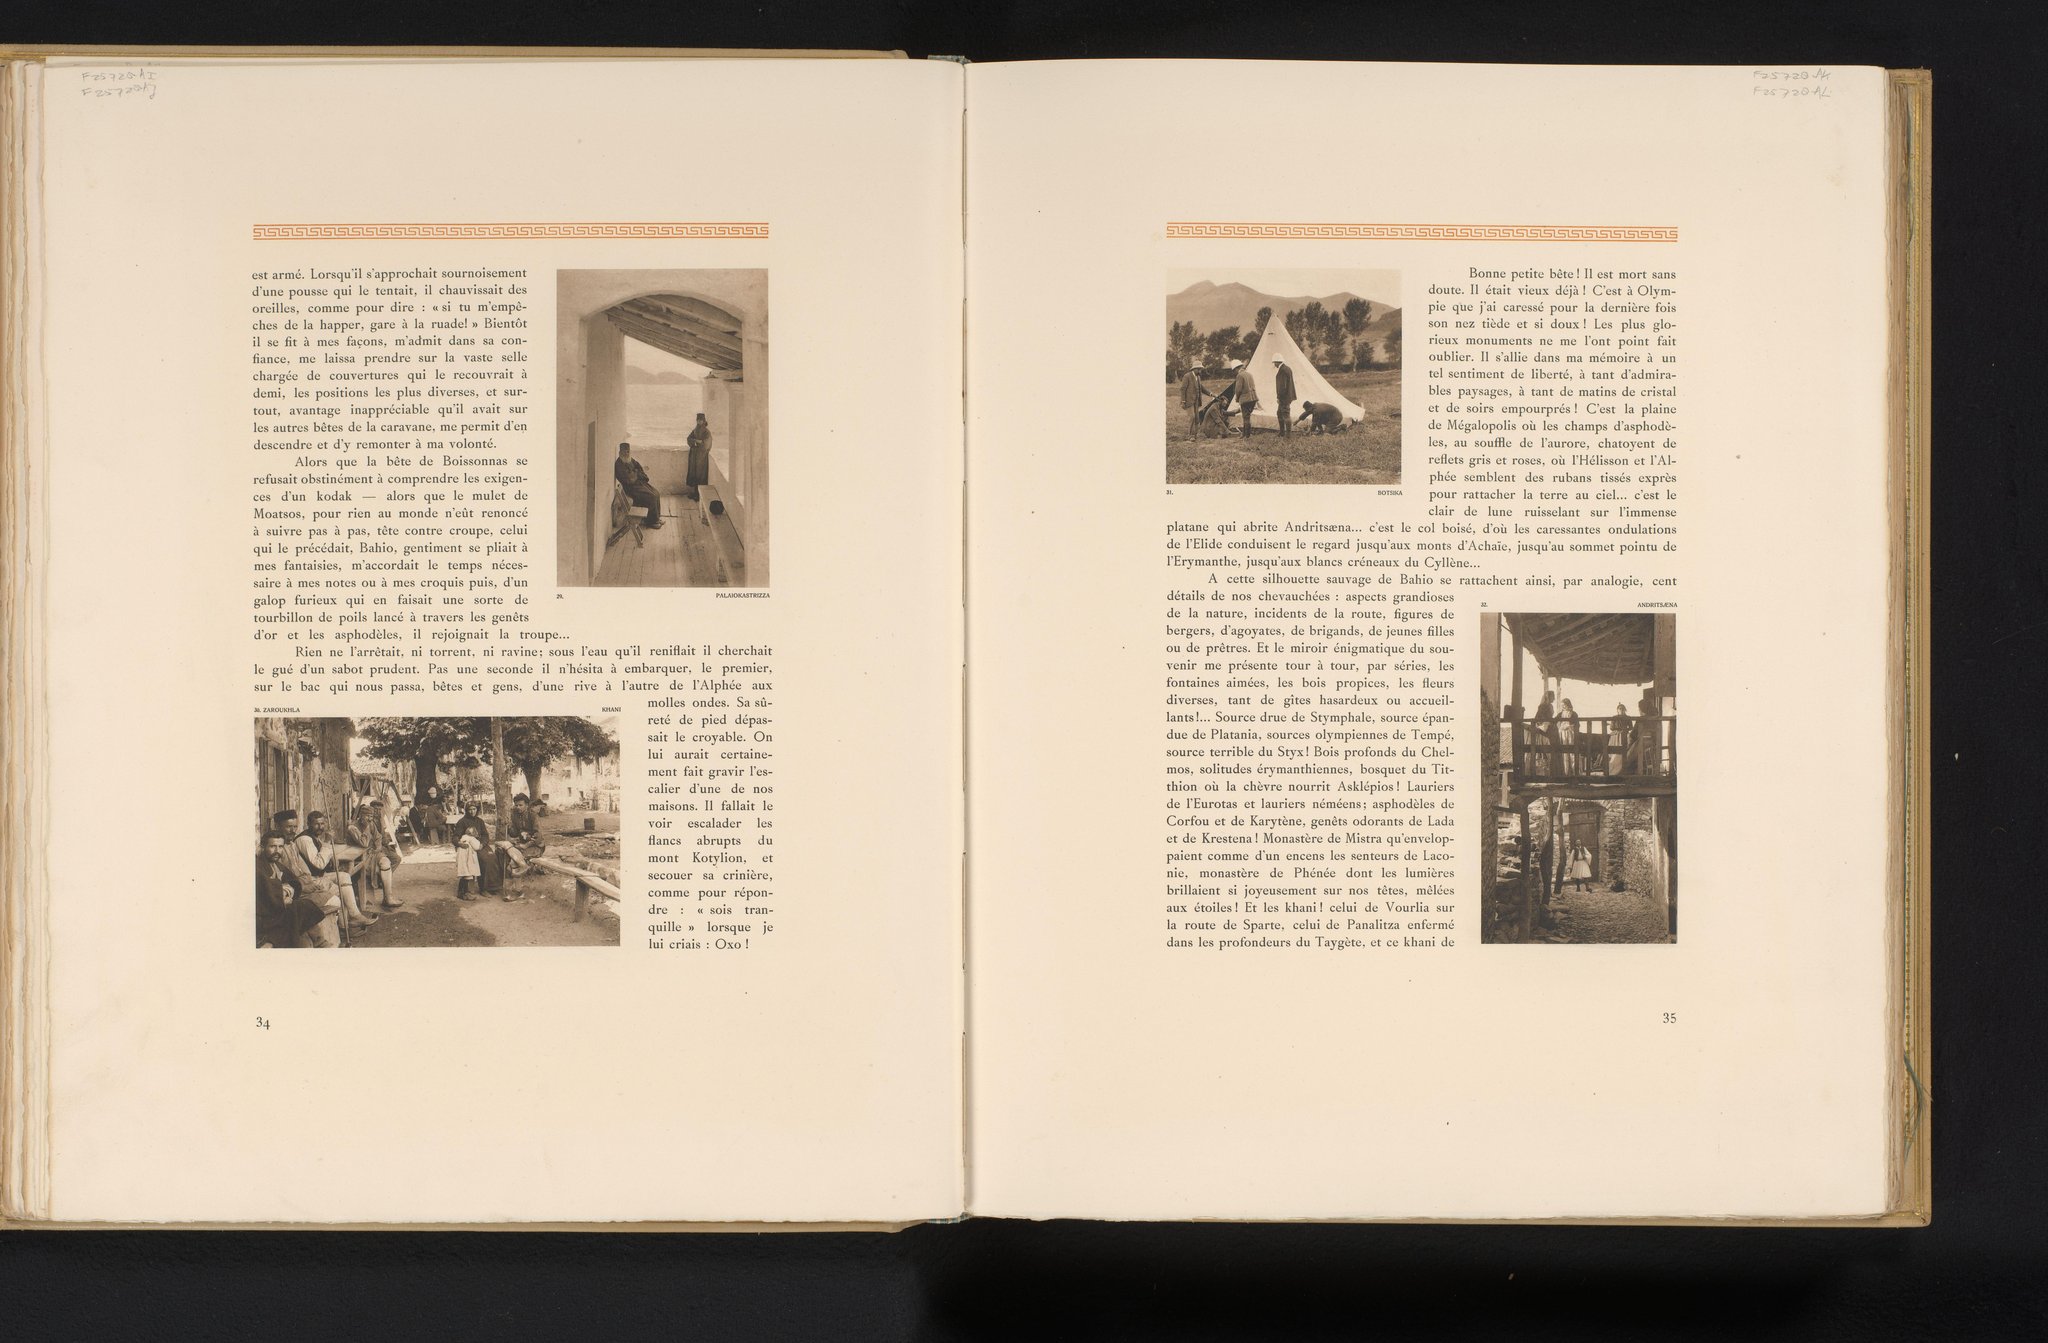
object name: photomechanical print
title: Zaroukhla, Khani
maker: frédéric boissonnas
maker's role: fotograaf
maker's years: 1858-1946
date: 1905-1910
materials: paper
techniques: photograph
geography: berlin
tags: wandering communities: romani or roma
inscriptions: number: ‘30.’